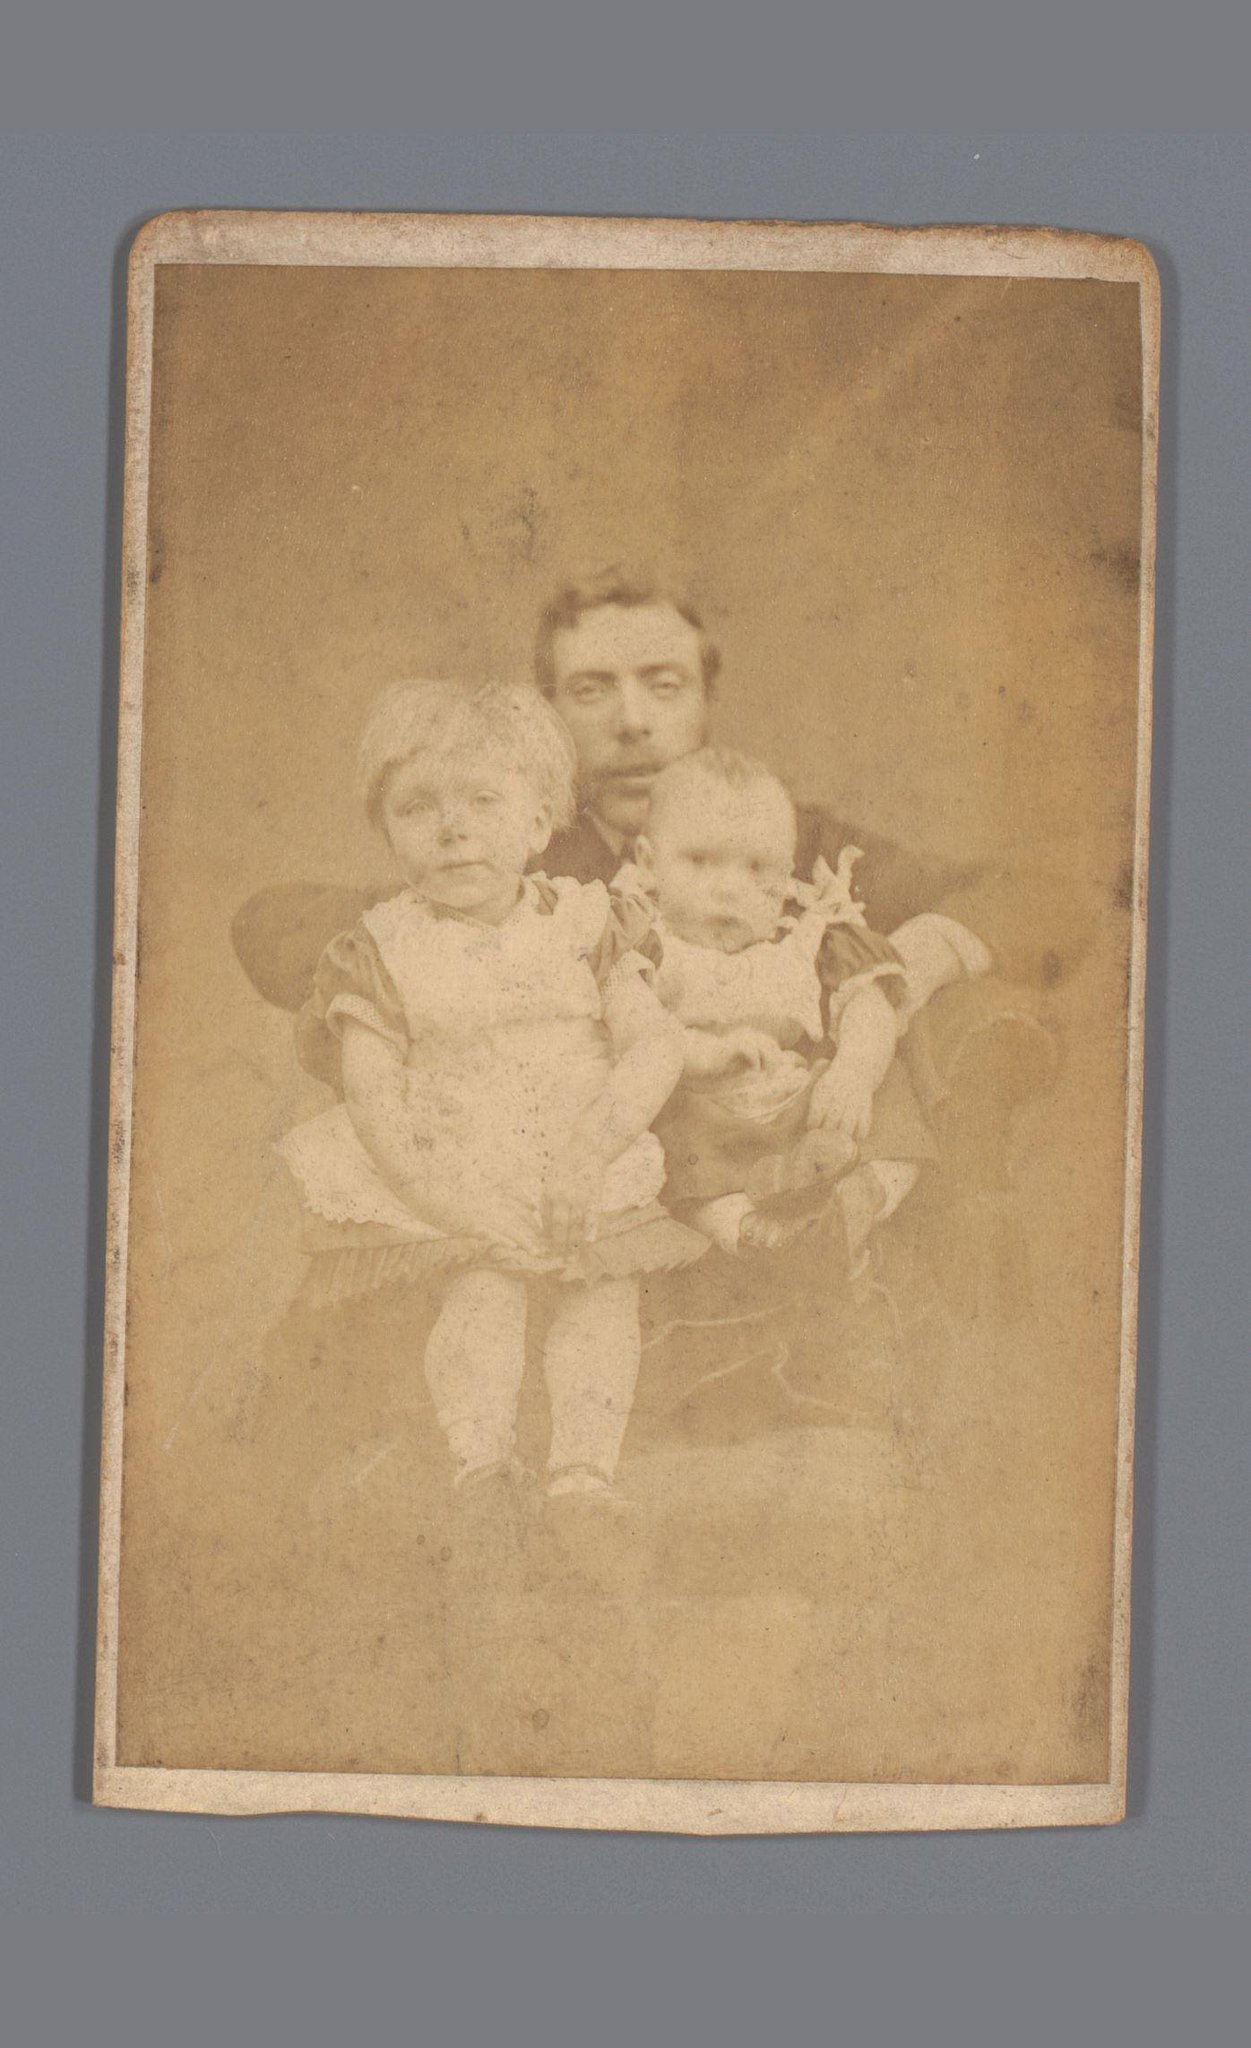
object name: photograph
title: Portret van een onbekende man met twee kinderen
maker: john george kirby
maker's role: fotograaf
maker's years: 1849-1913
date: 1855-1885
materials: cardboard, paper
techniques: albumen print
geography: london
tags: anonymous historical person portrayed, father and child(ren), man and child(ren) (family group)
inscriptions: inscription: ‘Negatives kept. Copies or Enlargements/ can be had at any time.’, address: ‘295, Edgware Road/ W./ LONDON.’